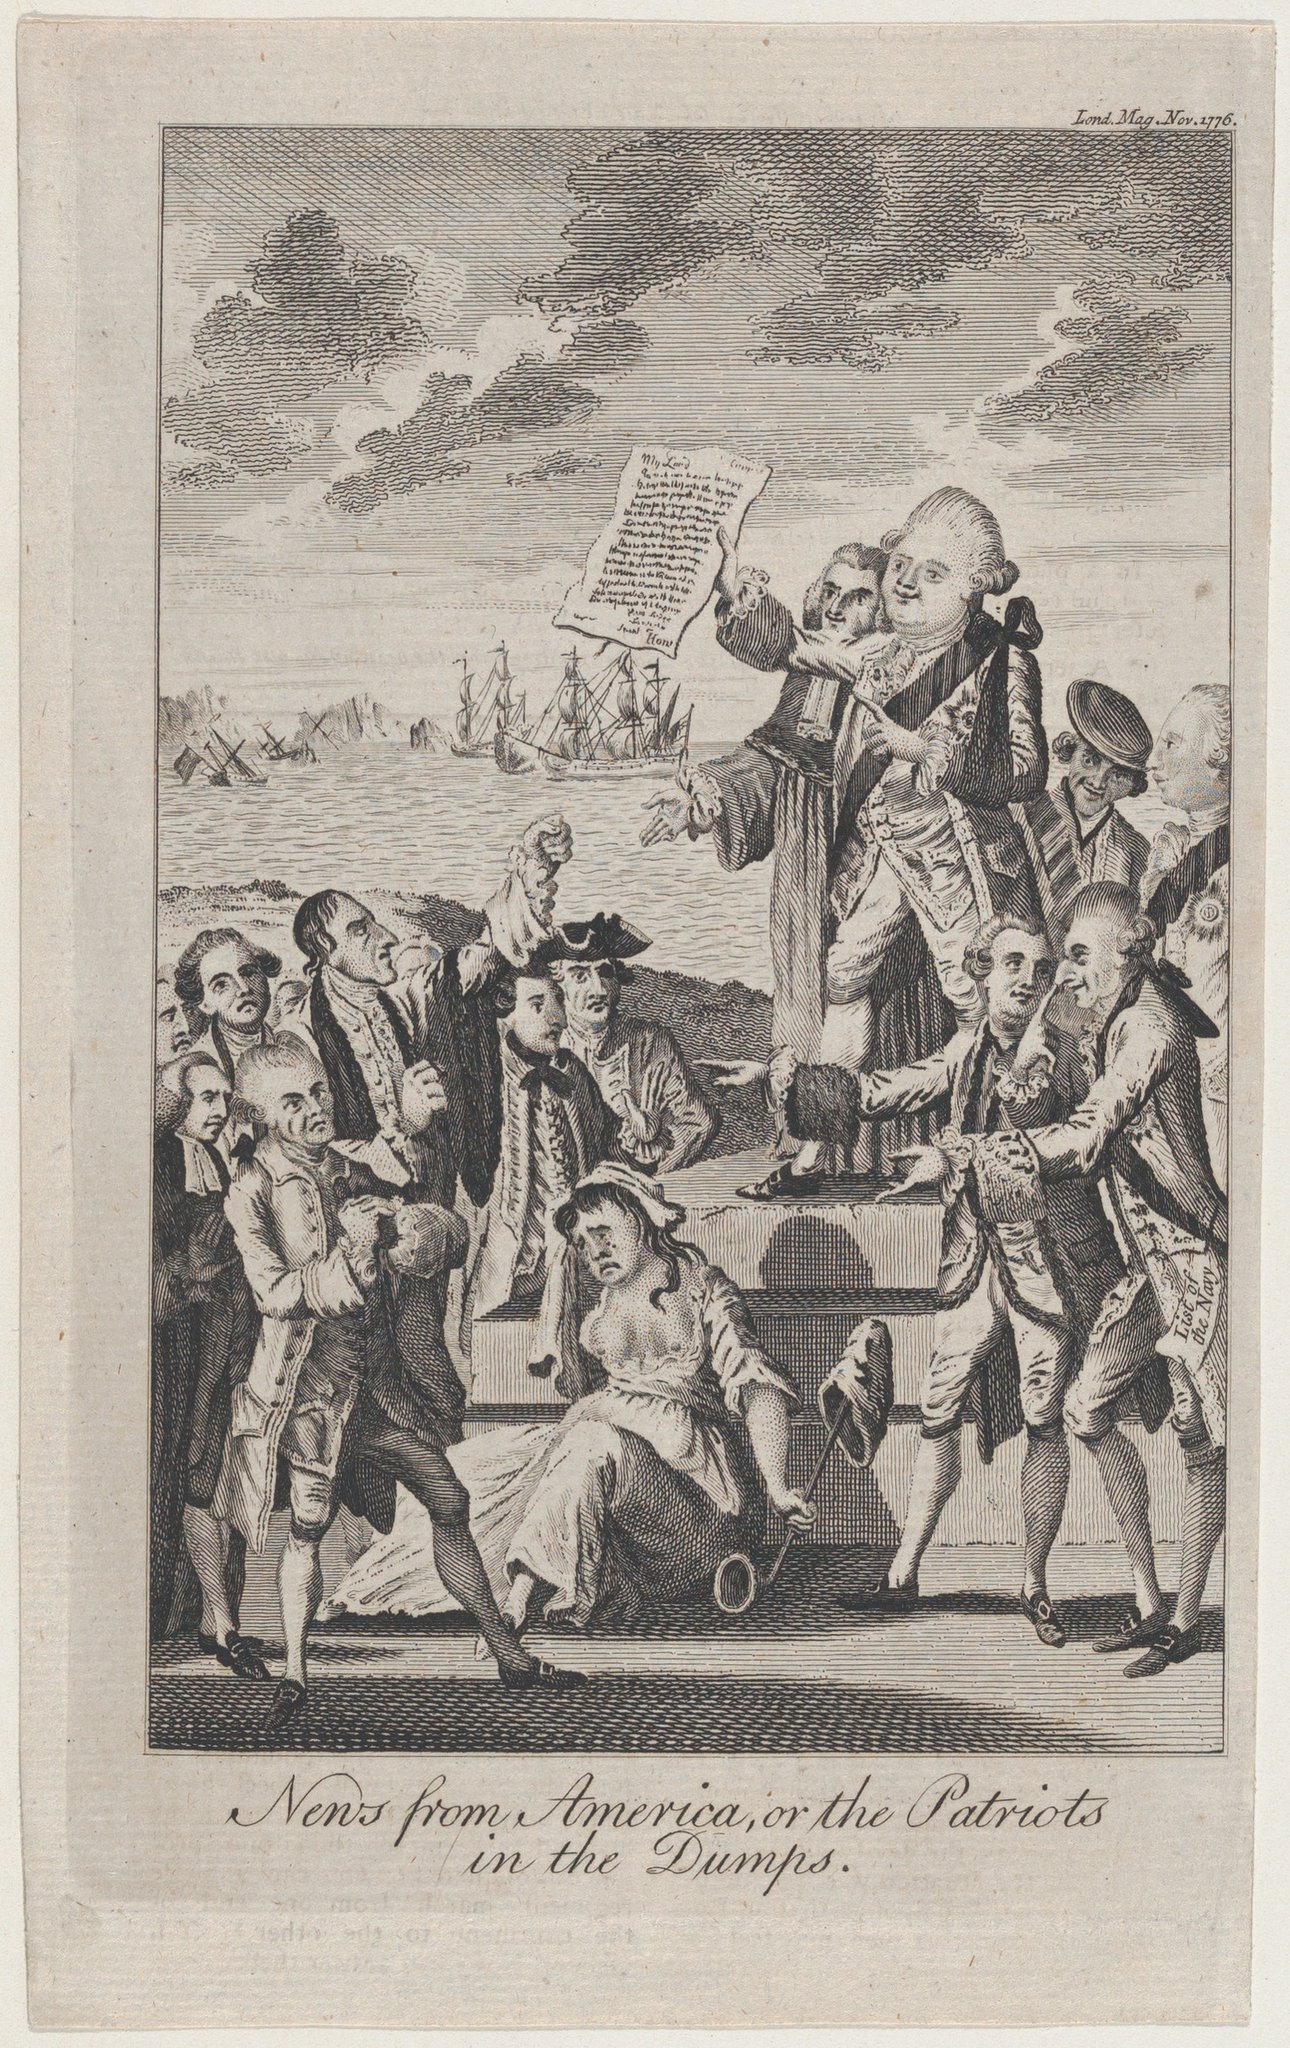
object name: print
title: News from America, or the Patriots in the Dumps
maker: anonymous, british, 18th century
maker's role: artist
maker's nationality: british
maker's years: 1700-1800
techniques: engraving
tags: satire,american revolution,men,women,politics